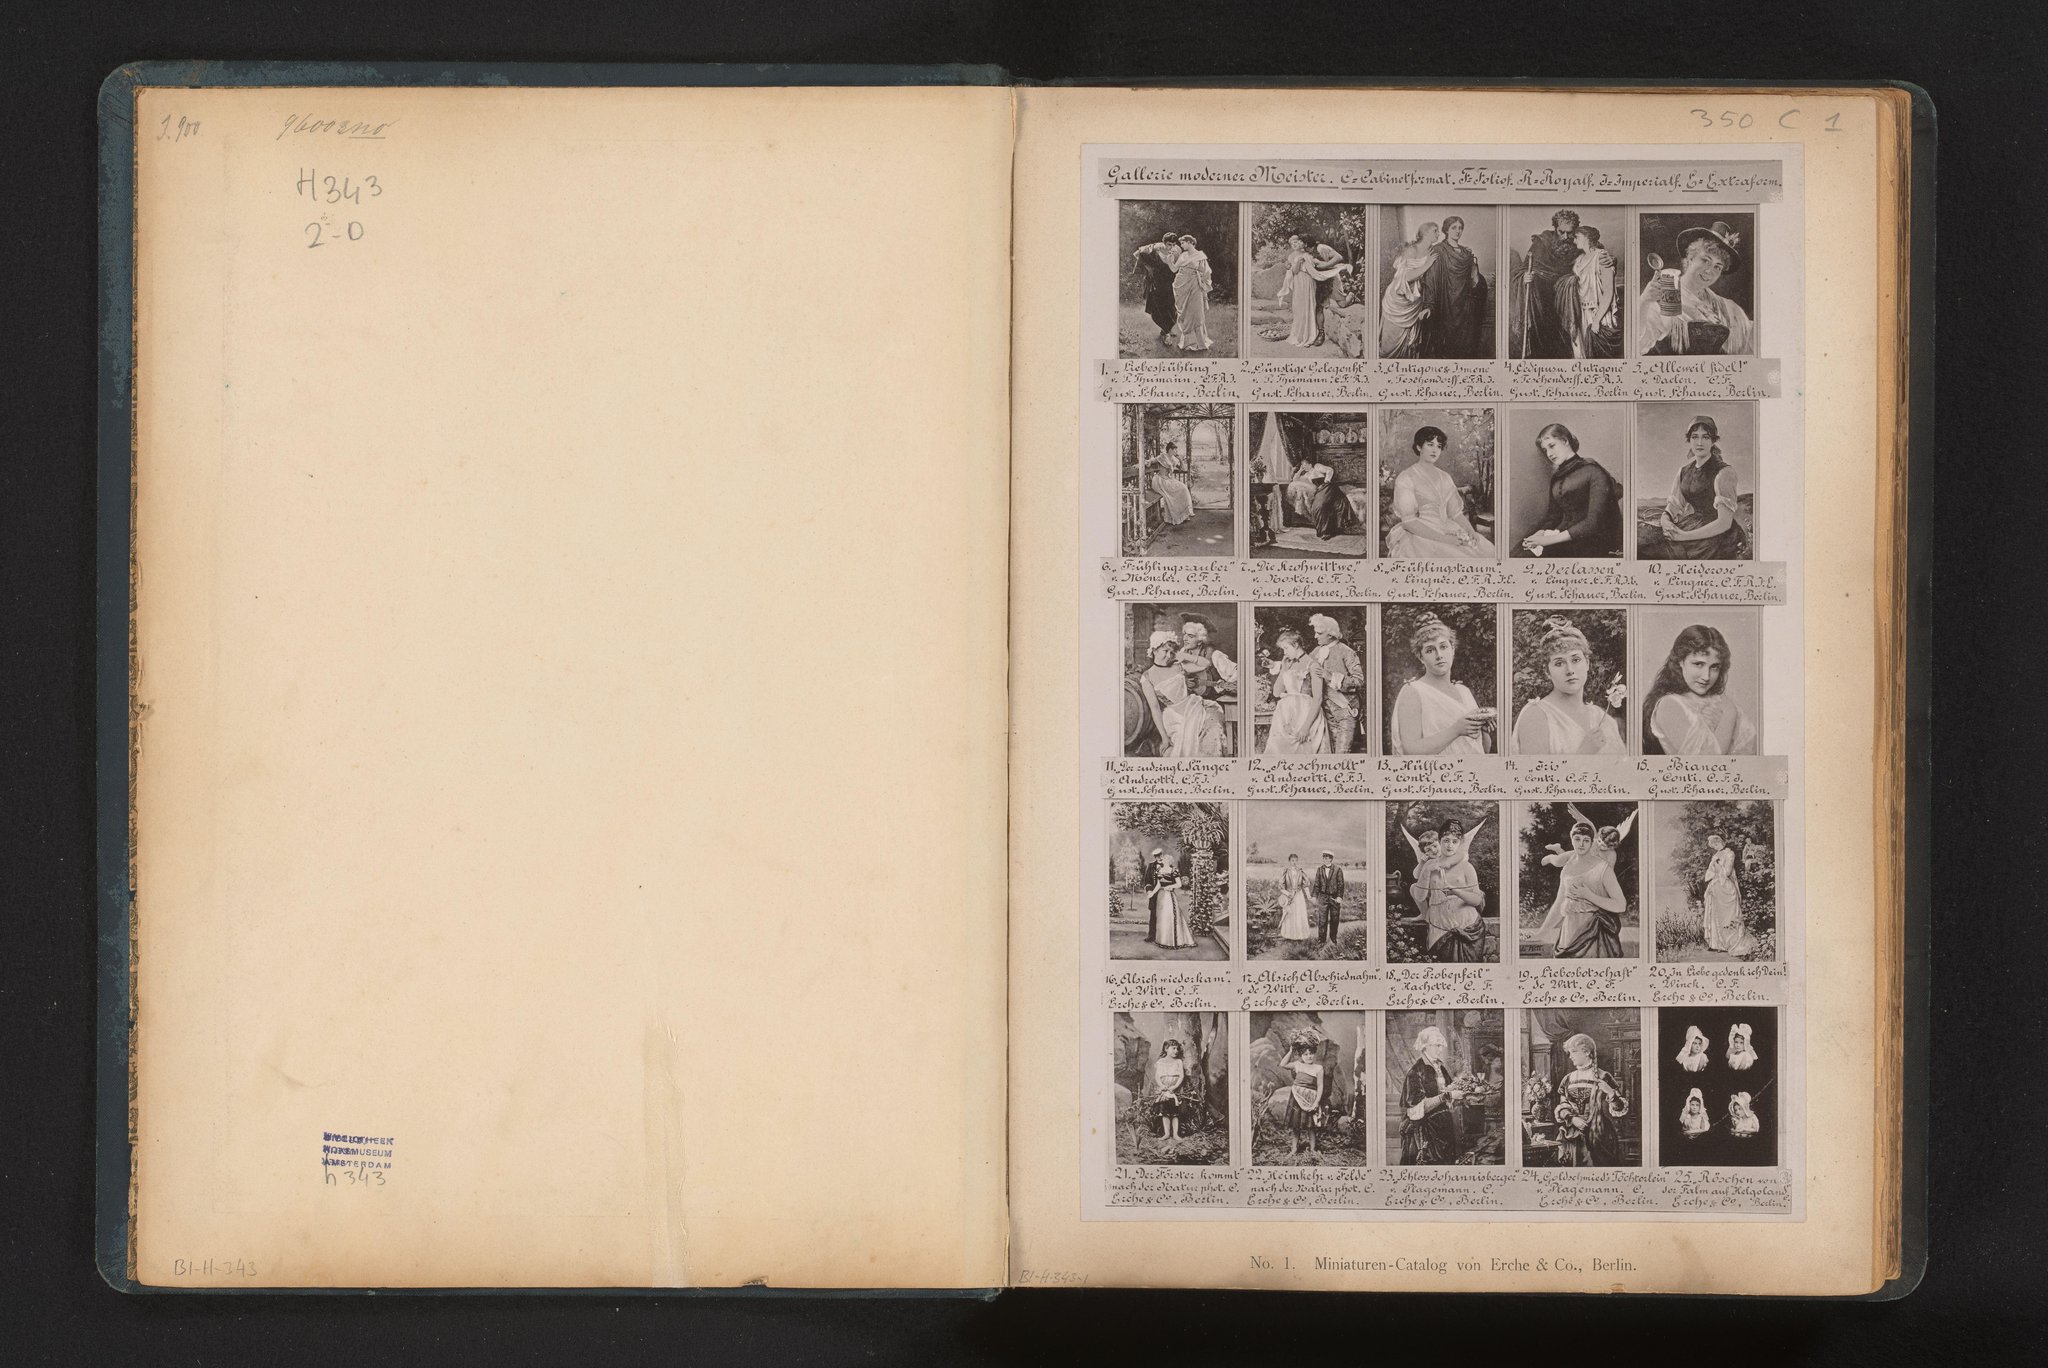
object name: page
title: Fotoreproducties van 25 geschilderde portretten en taferelen met onbekende mensen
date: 1880-1885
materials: paper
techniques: photograph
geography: berlin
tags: anonymous historical person portrayed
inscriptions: number: ‘No. 1.’